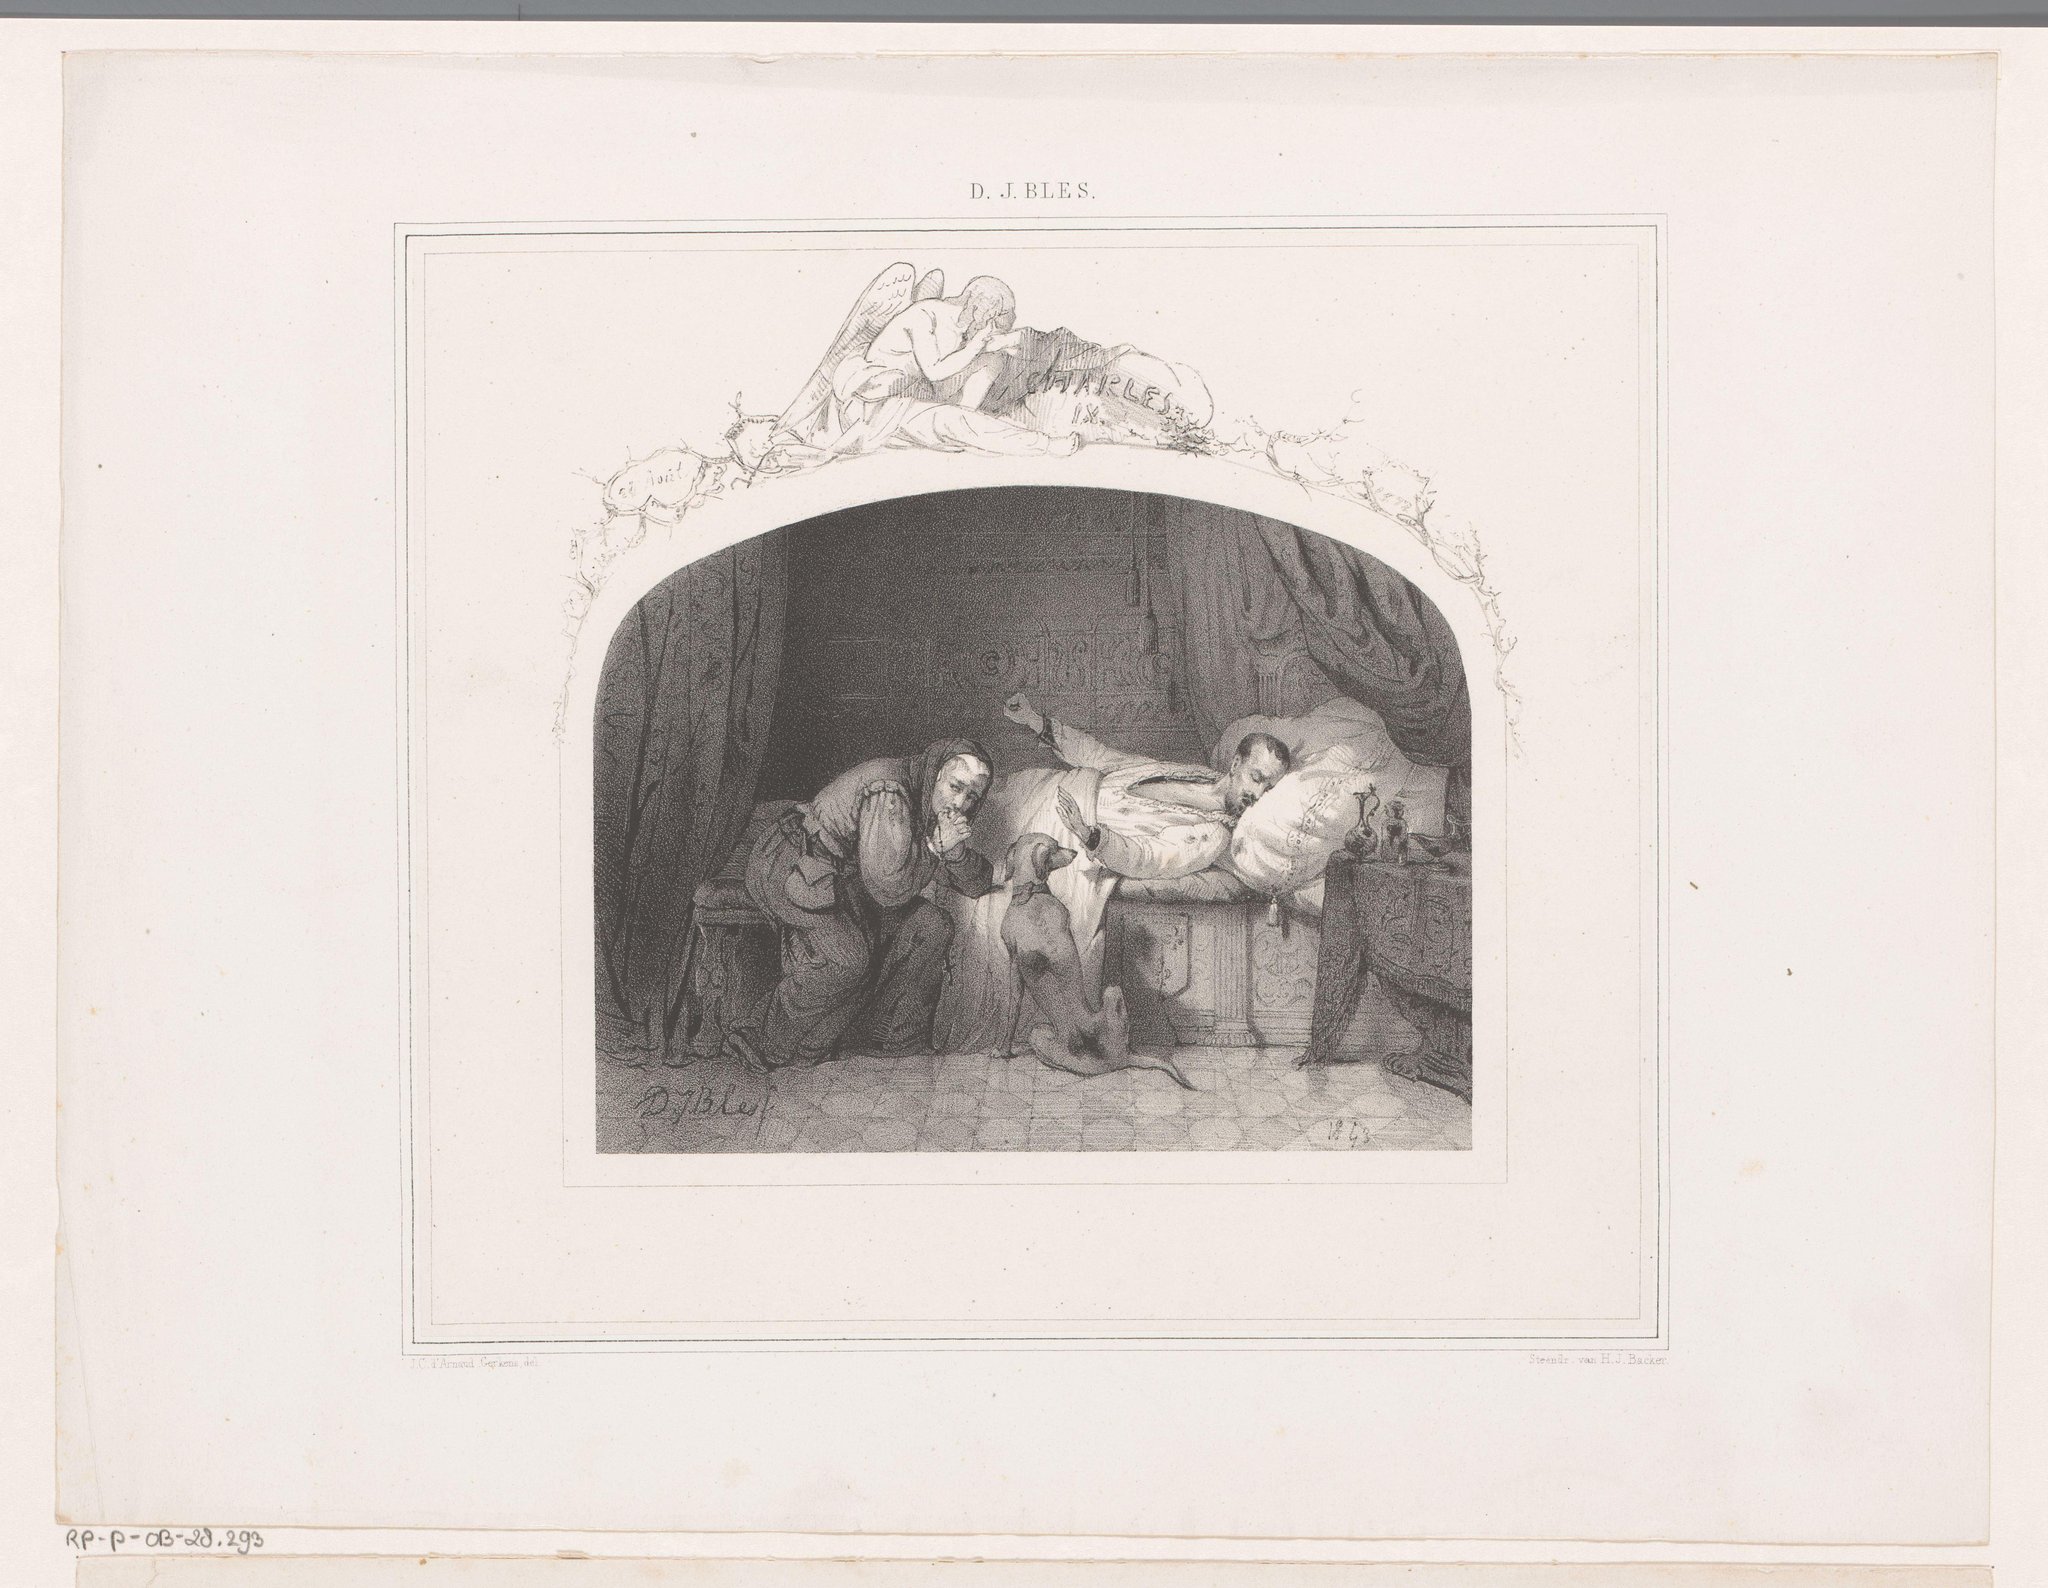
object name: print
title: Ziekbed van Charles IX van Frankrijk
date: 1843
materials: paper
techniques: lithograph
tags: karel ix (koning van frankrijk), sick-bed, saying the rosary, dog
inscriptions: collector's mark: Lugt 2228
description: De koning ligt in bed. Hij heeft zijn armen uitgstrekt en zijn hoofd weggedraaid. Naast hem zit een figuur, biddend met een rozenkrans, en een hond. Karel IX overleed in 1574 op 23-jarige leeftijd aan tuberculose.